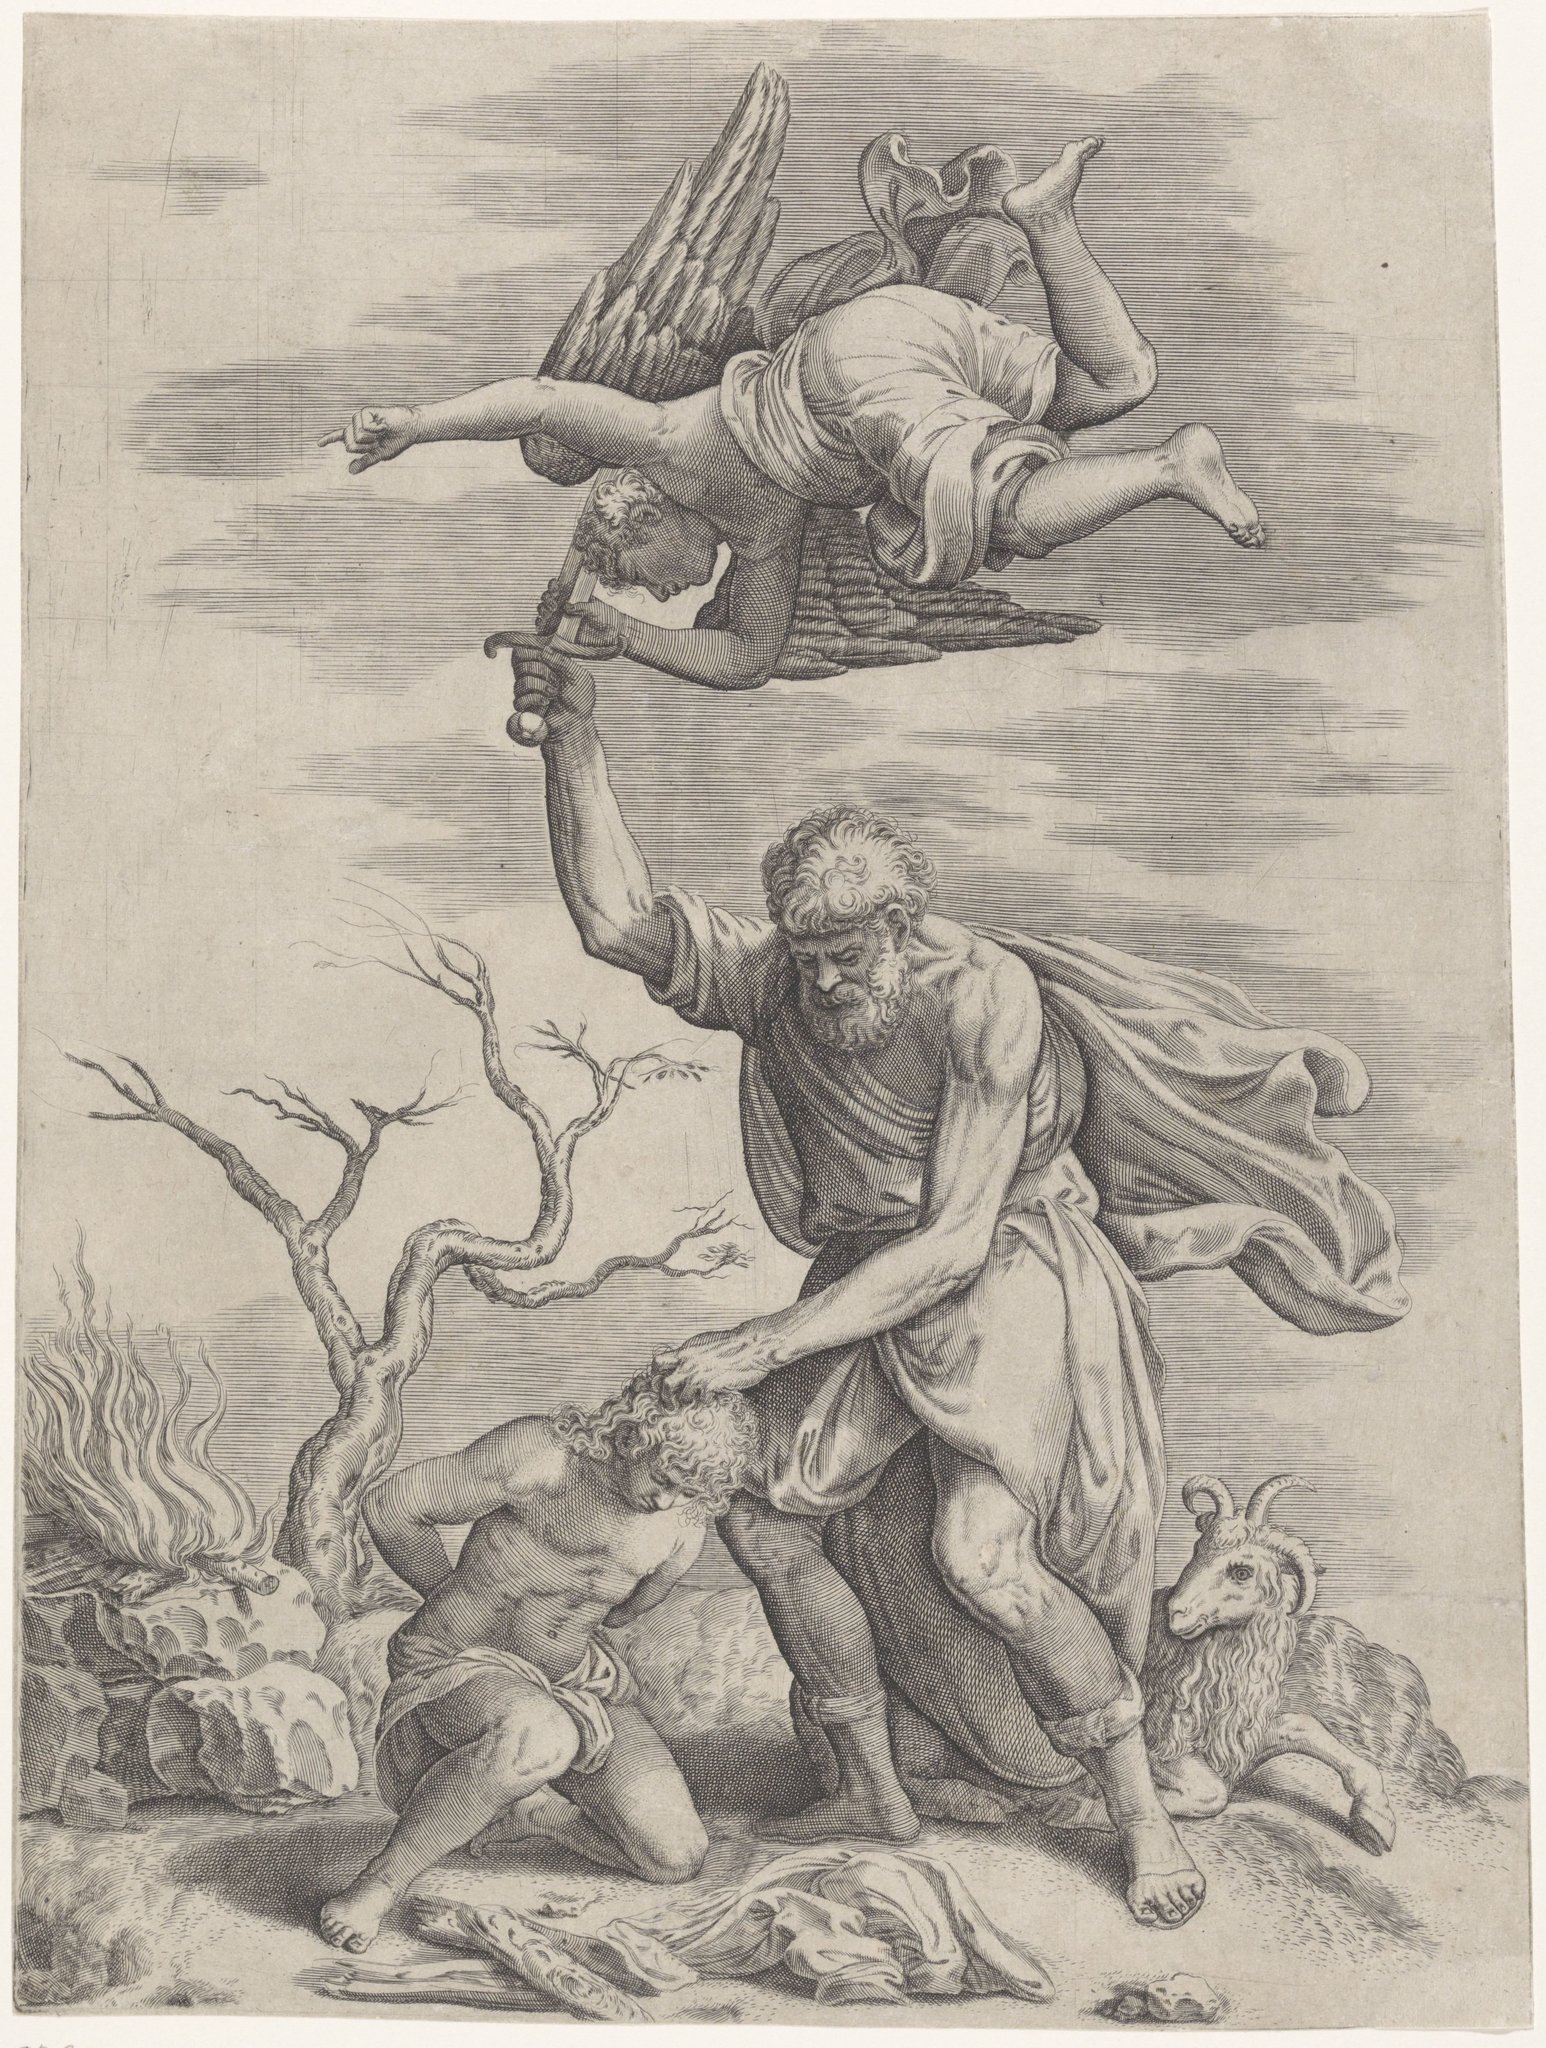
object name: print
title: Offer van Isaak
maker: battista franco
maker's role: draughtsman, painter, print maker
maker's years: 1510-1561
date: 1520-1561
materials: paper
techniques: engraving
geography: italy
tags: the sacrifice of isaac (genesis 22)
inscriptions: collector's mark: Lugt 2228, collector's mark: Lugt 2760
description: Abraham staat op het punt met zijn zwaard Isaak, die geknield voor hem zit, te onthoofden. Een engel in de lucht grijpt het zwaard. Links een brandend offerblok, rechts een ram.